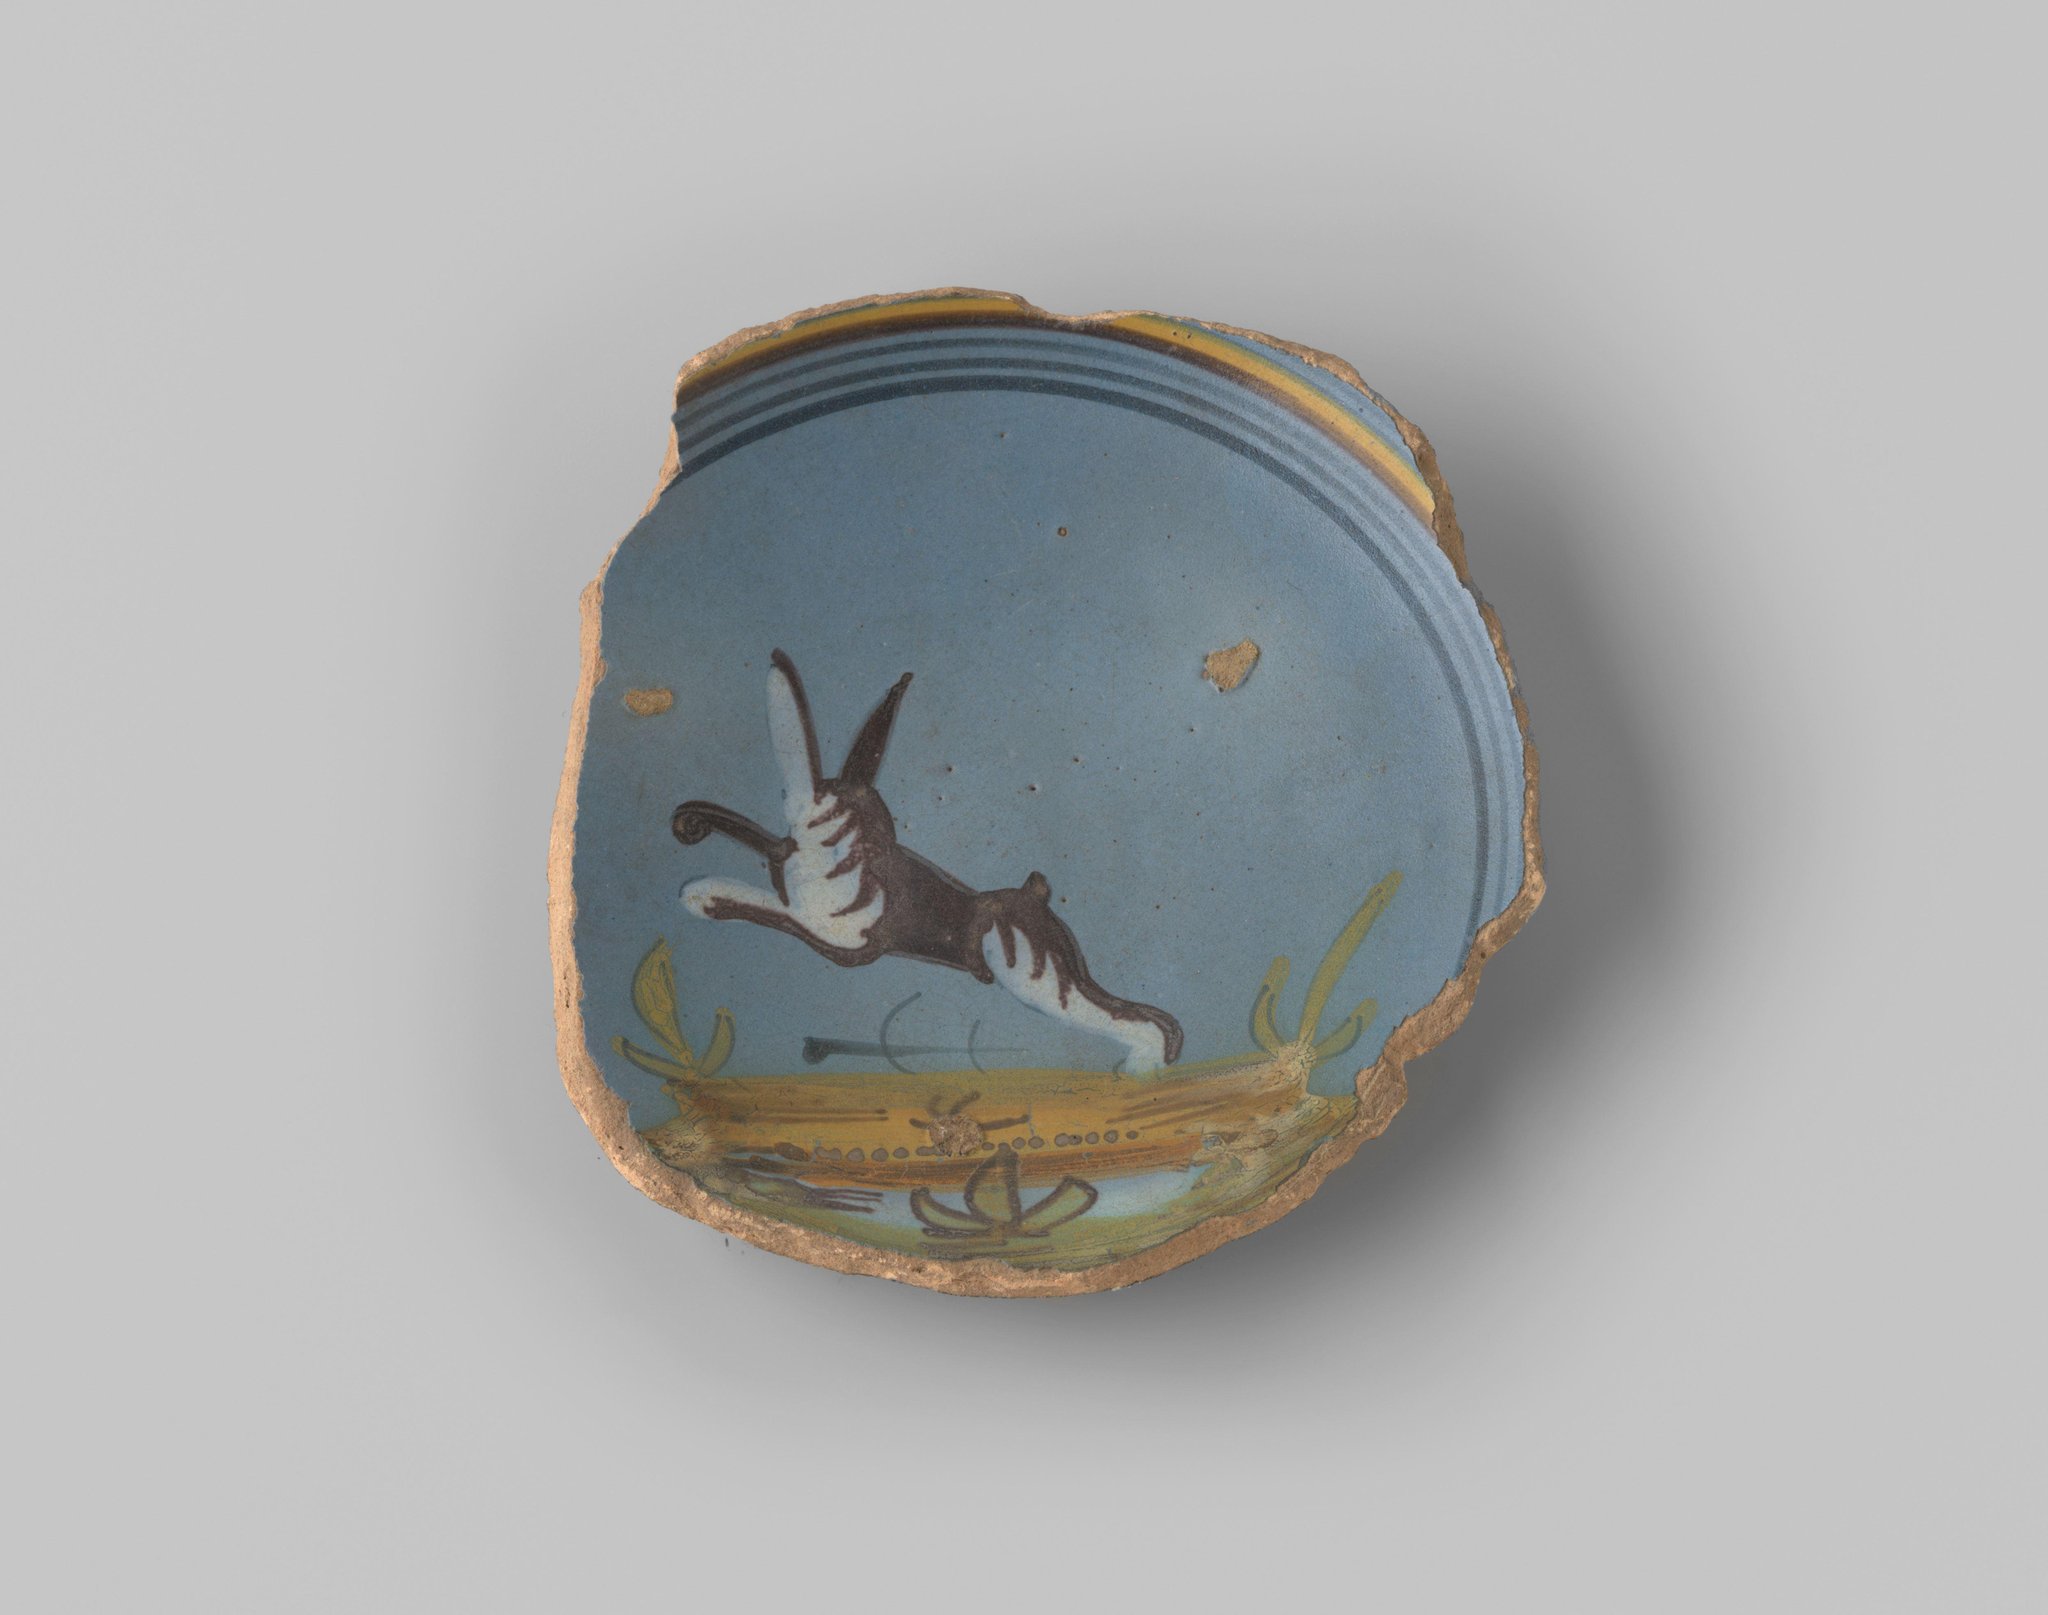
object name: fragment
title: Scherf van rossigbakkend aardewerk, met standring, aan de voorzijde voorzien van blauw glazuur, waarop een voorstelling van een springende bruin-witte haas in een landschap in groen, blauw en geel, met om het geheel heen enkele strepen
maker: Anonymous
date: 1600-1650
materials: earthenware, glaze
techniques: maiolica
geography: northern netherlands